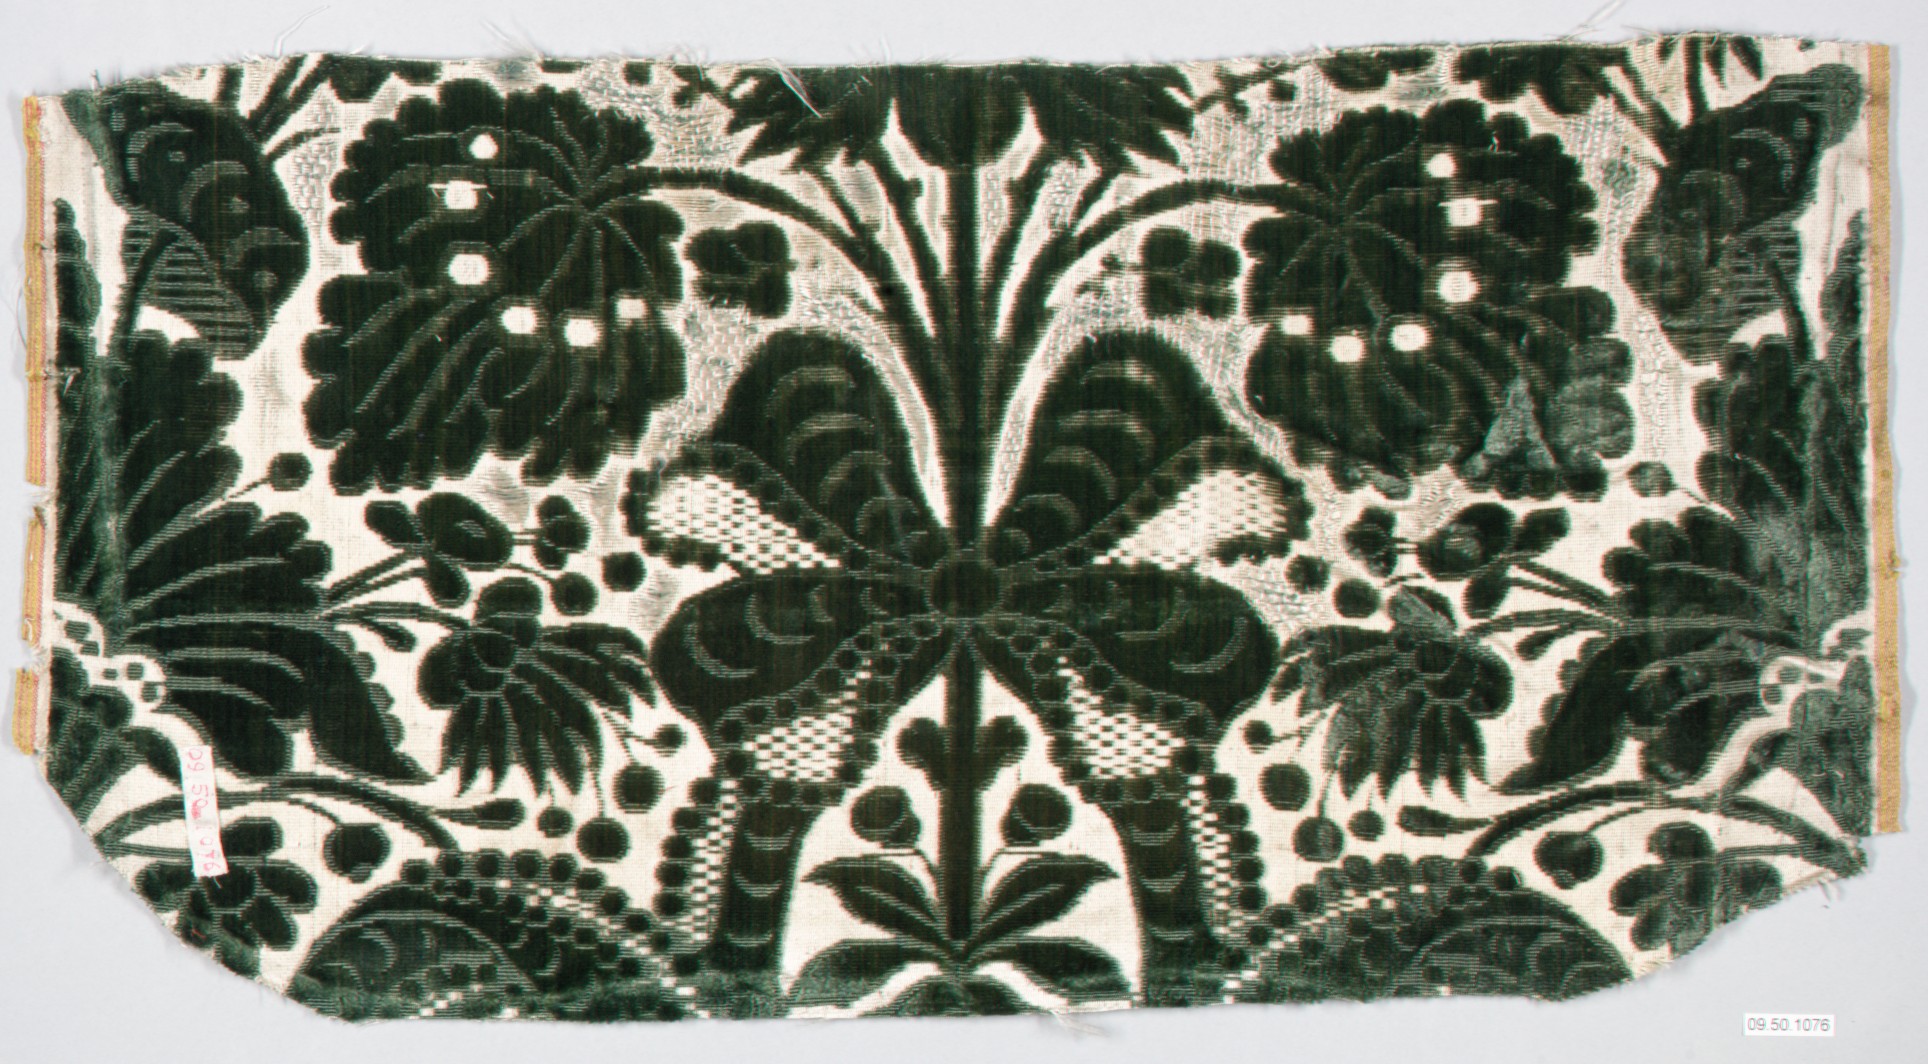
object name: piece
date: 1601-1700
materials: silk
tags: leaves